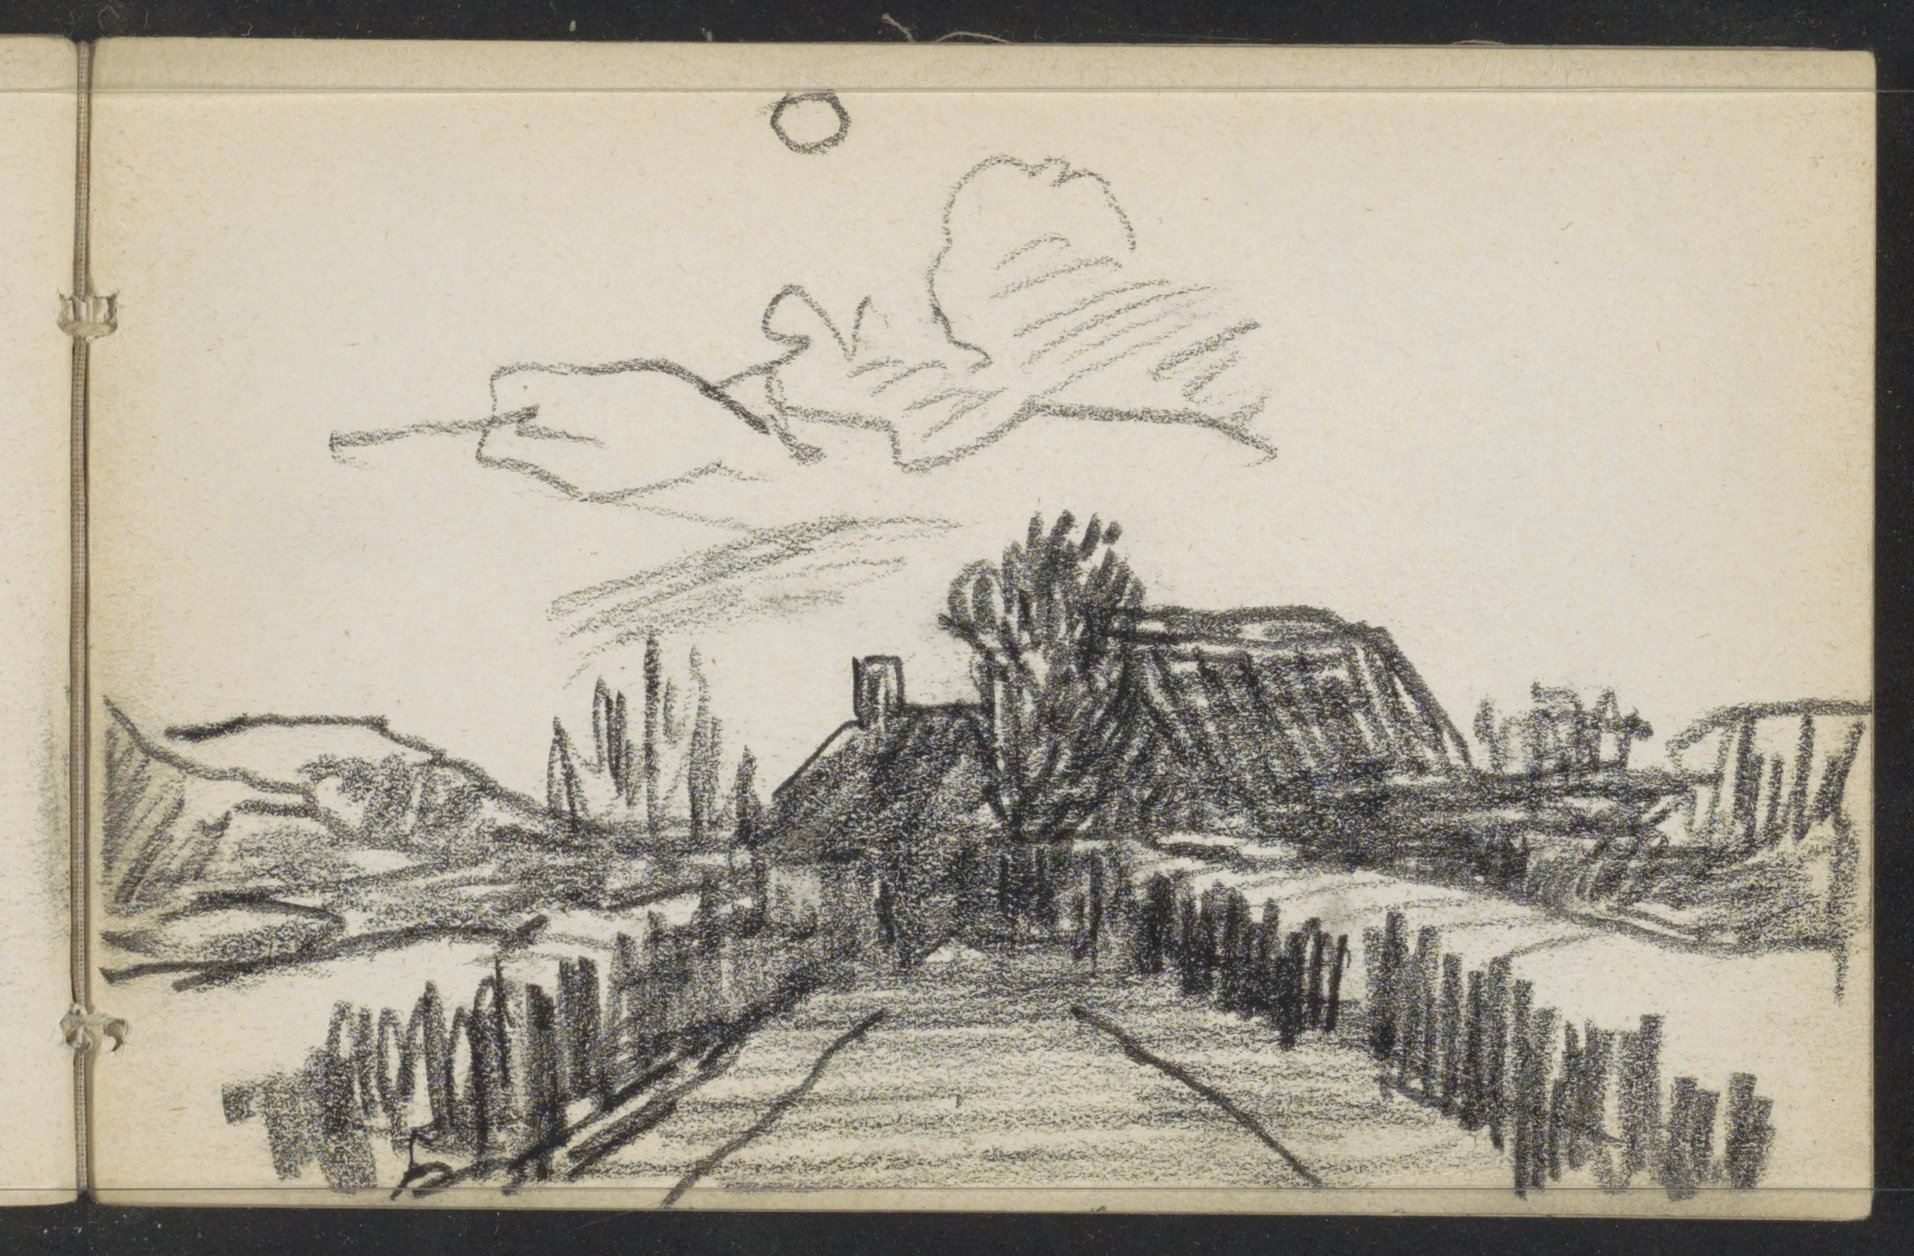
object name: sketchbook leaf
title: Pad richting een boerderij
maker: alexander shilling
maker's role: draughtsman, print maker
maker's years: 1859-1937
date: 1910-1923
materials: chalk, paper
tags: fence, wall, paling, farm (building)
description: Blad 16 recto uit een schetsboek met 26 bladen.